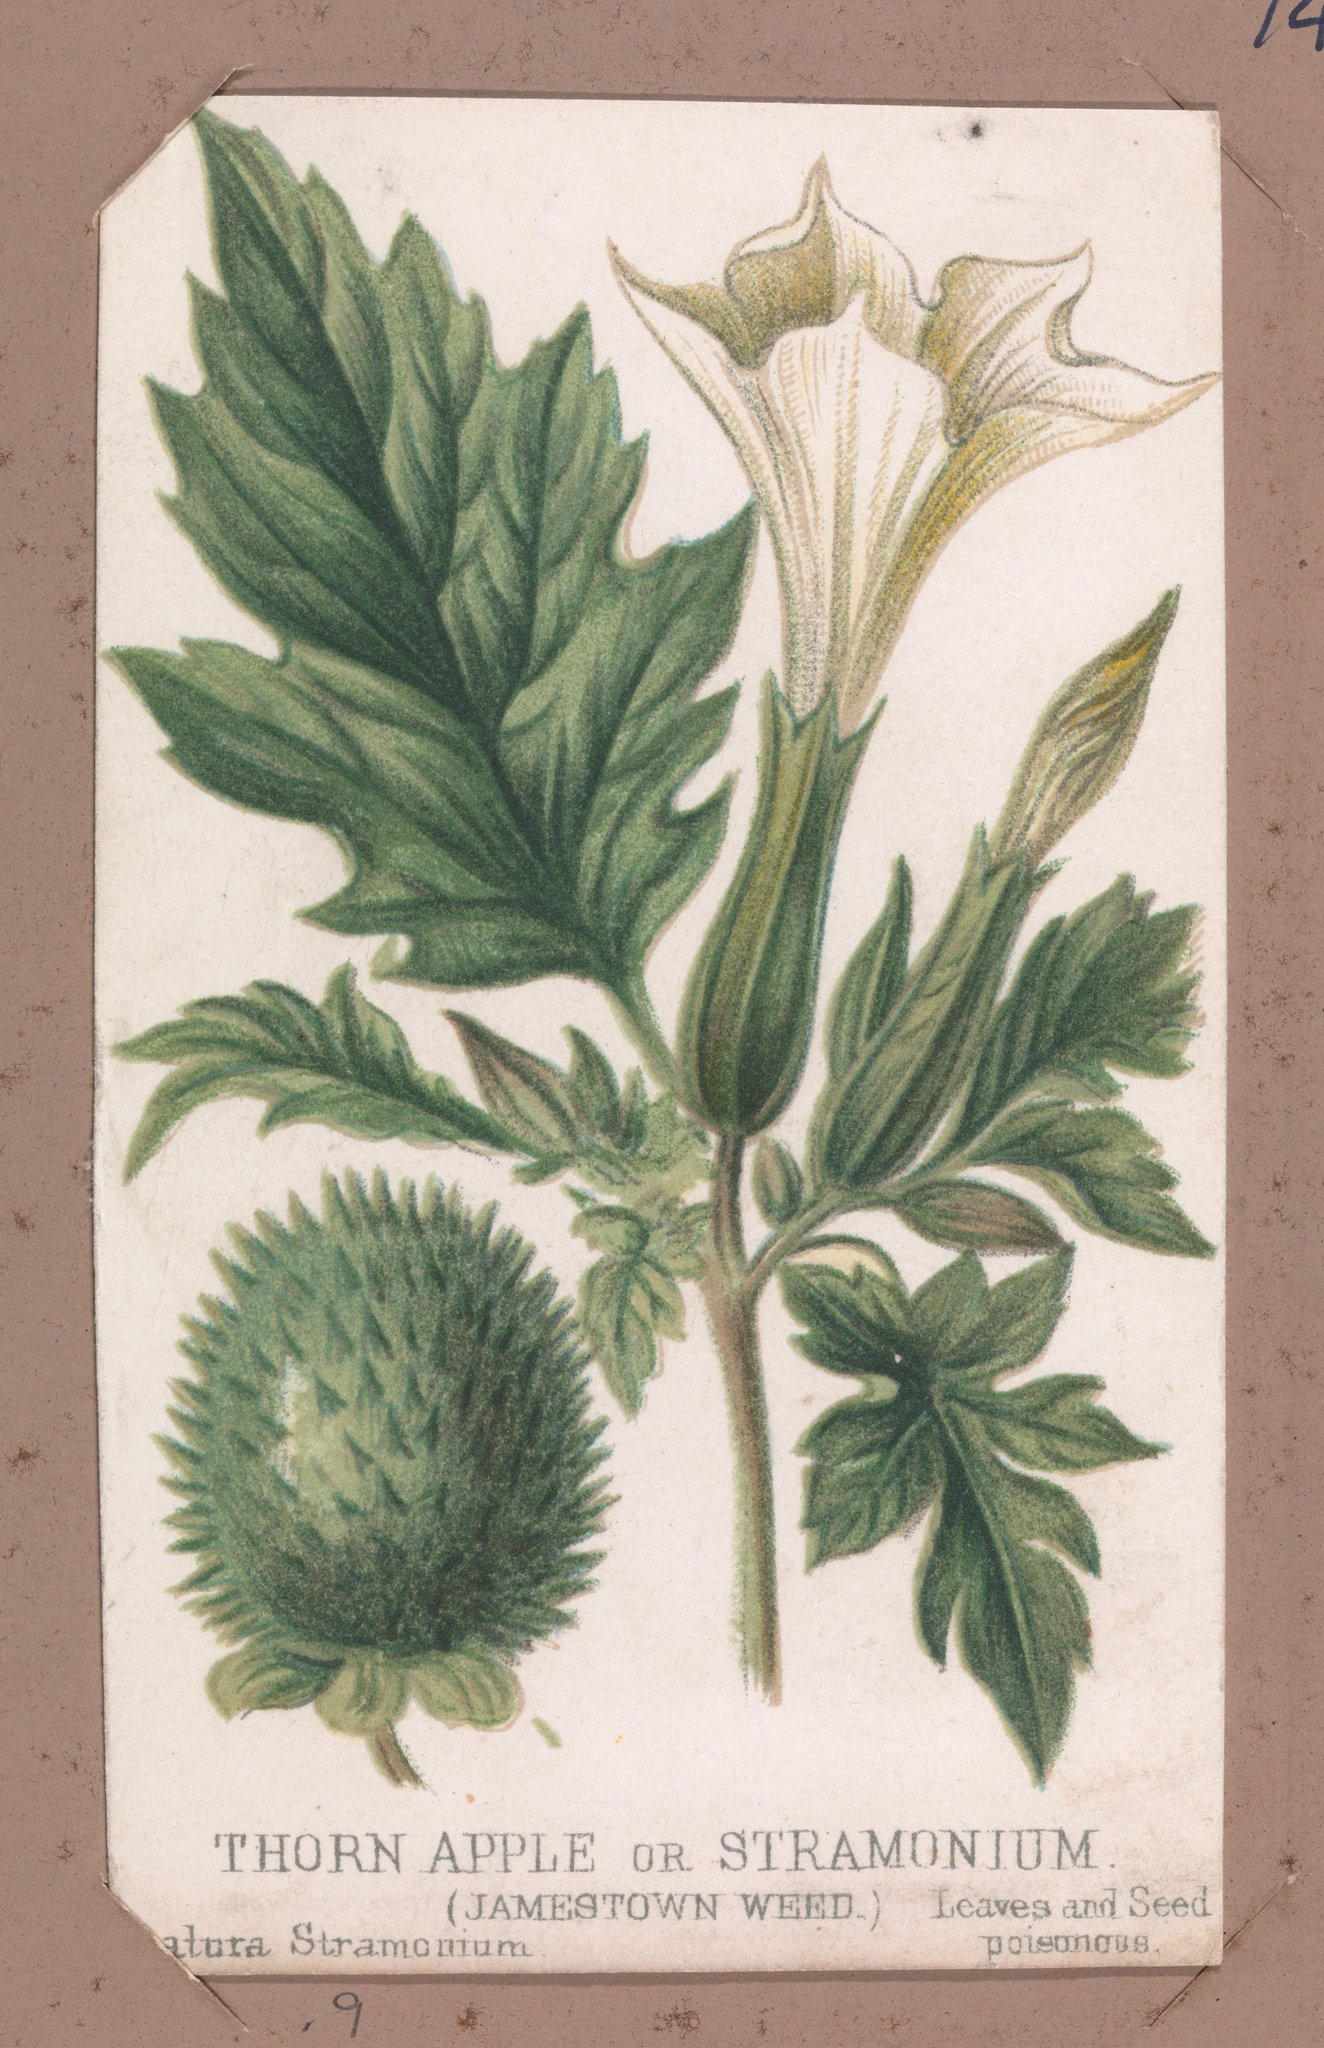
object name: album card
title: Thorn Apple or Stramonium from the Plants series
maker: louis prang & co.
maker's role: publisher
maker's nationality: american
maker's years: 1800-1950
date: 1862-1869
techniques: lithograph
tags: plants